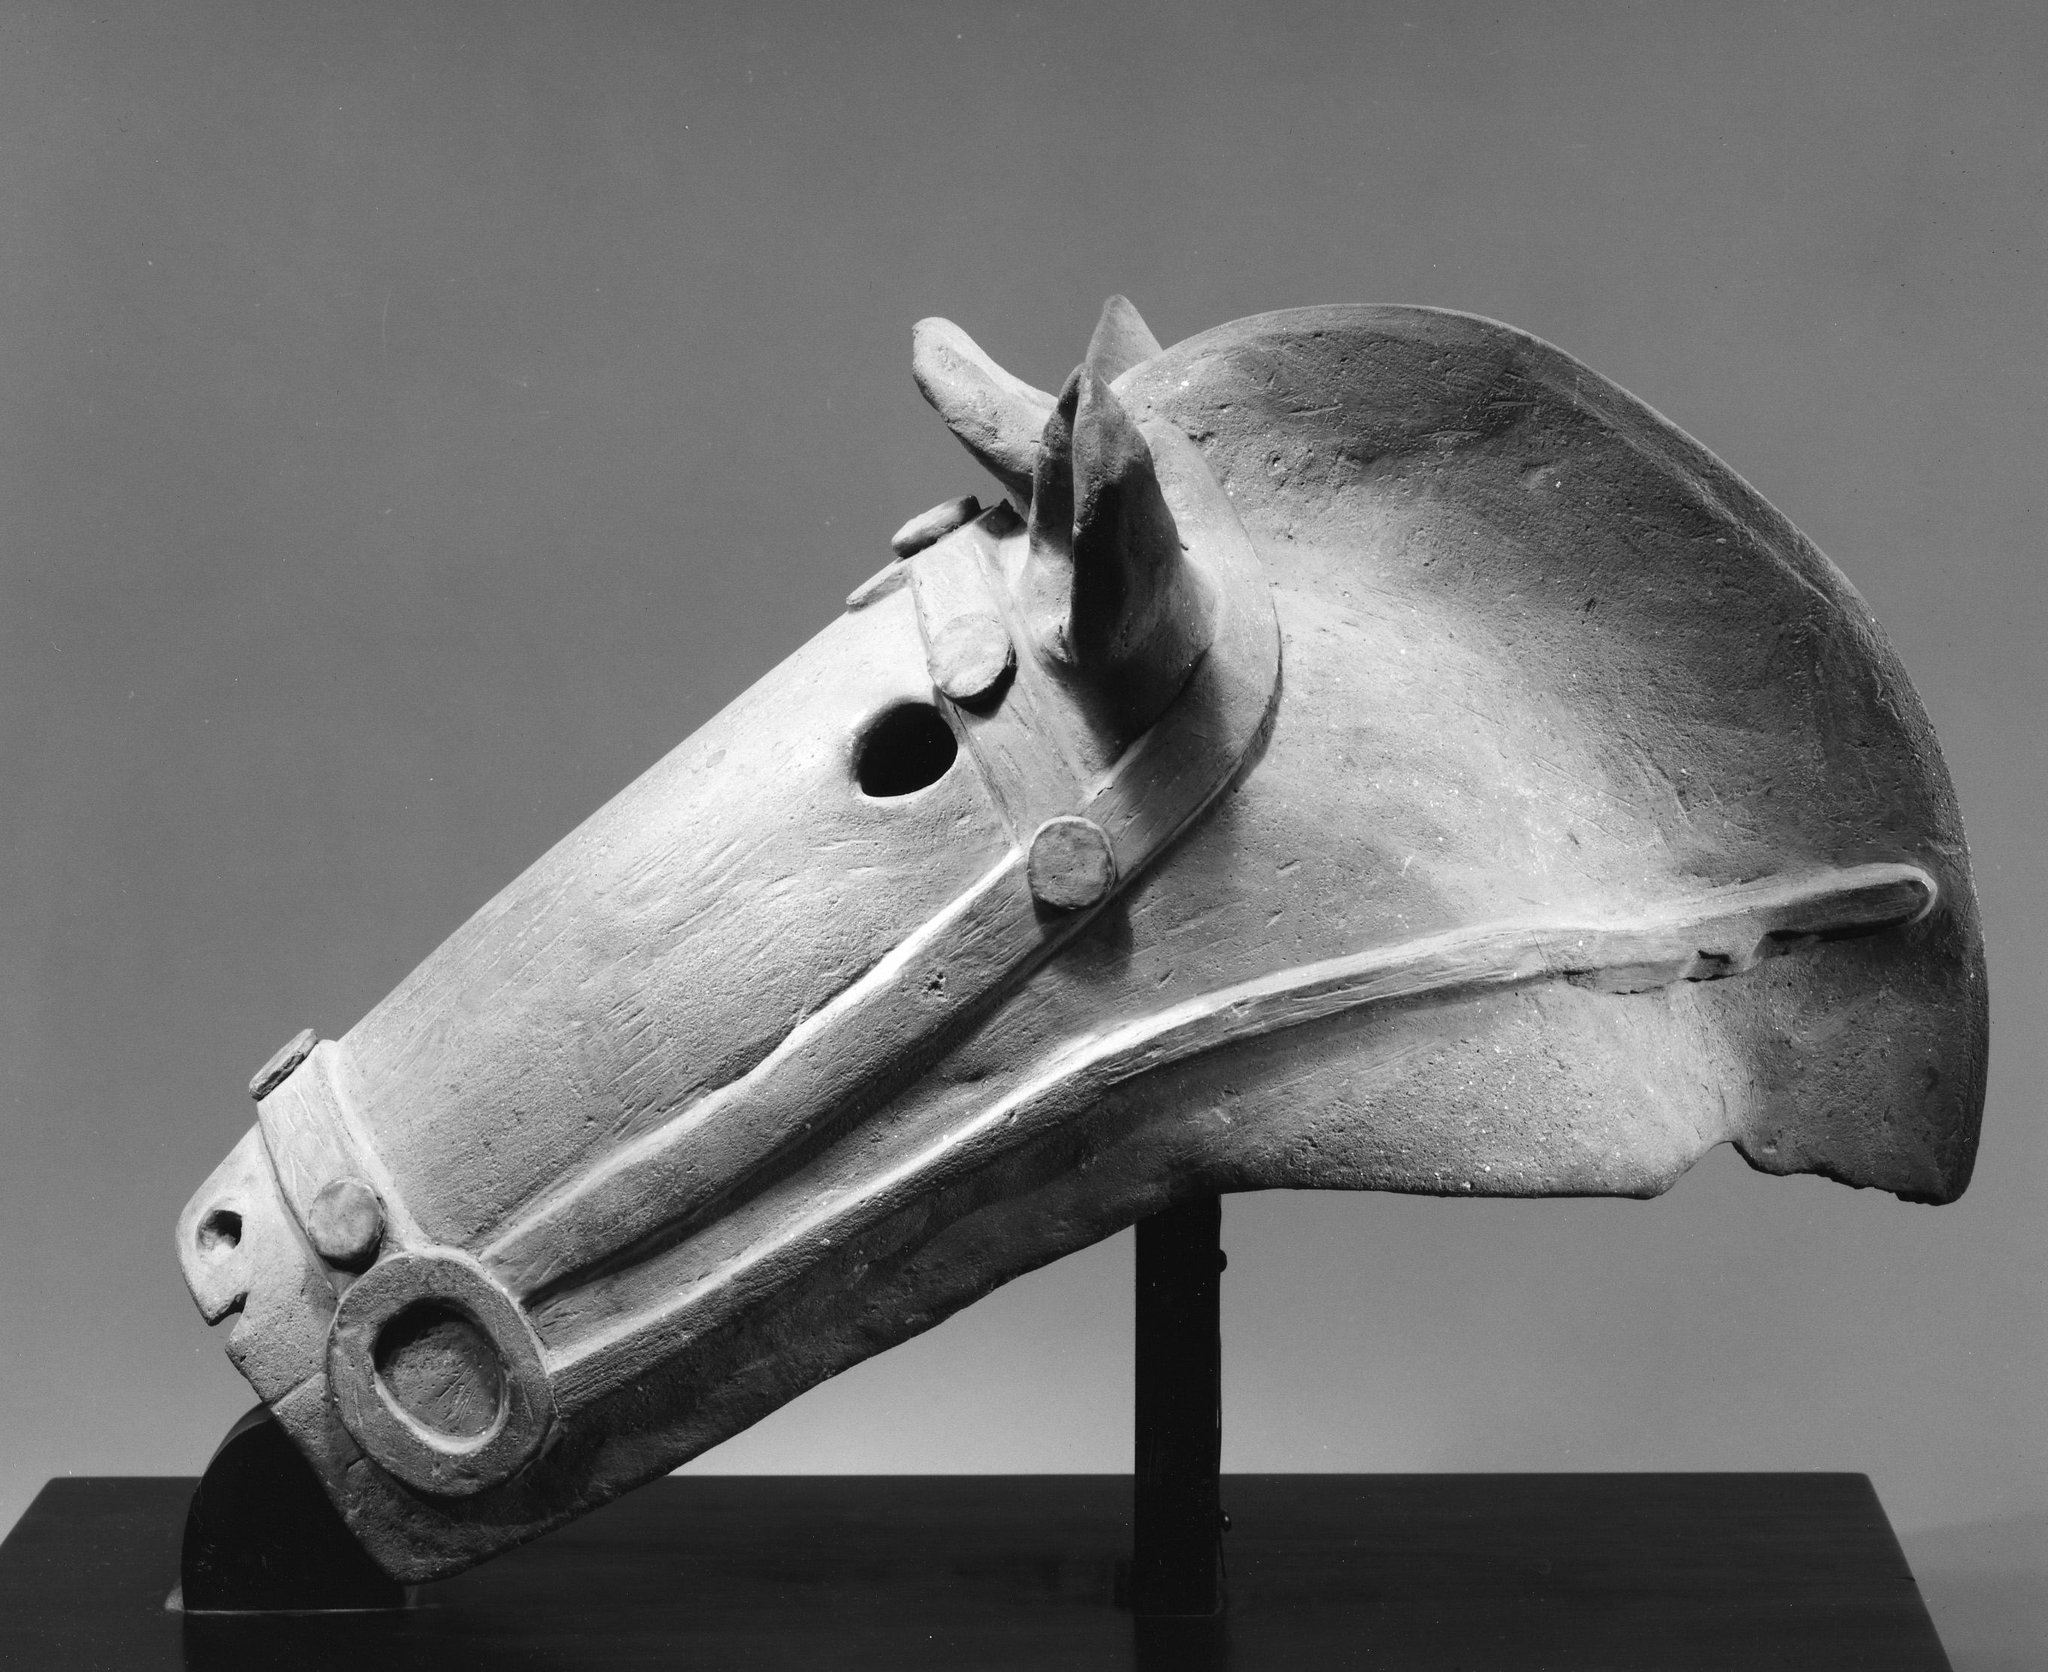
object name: haniwa head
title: Haniwa Horse's Head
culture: japanese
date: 501-600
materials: earthenware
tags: horses